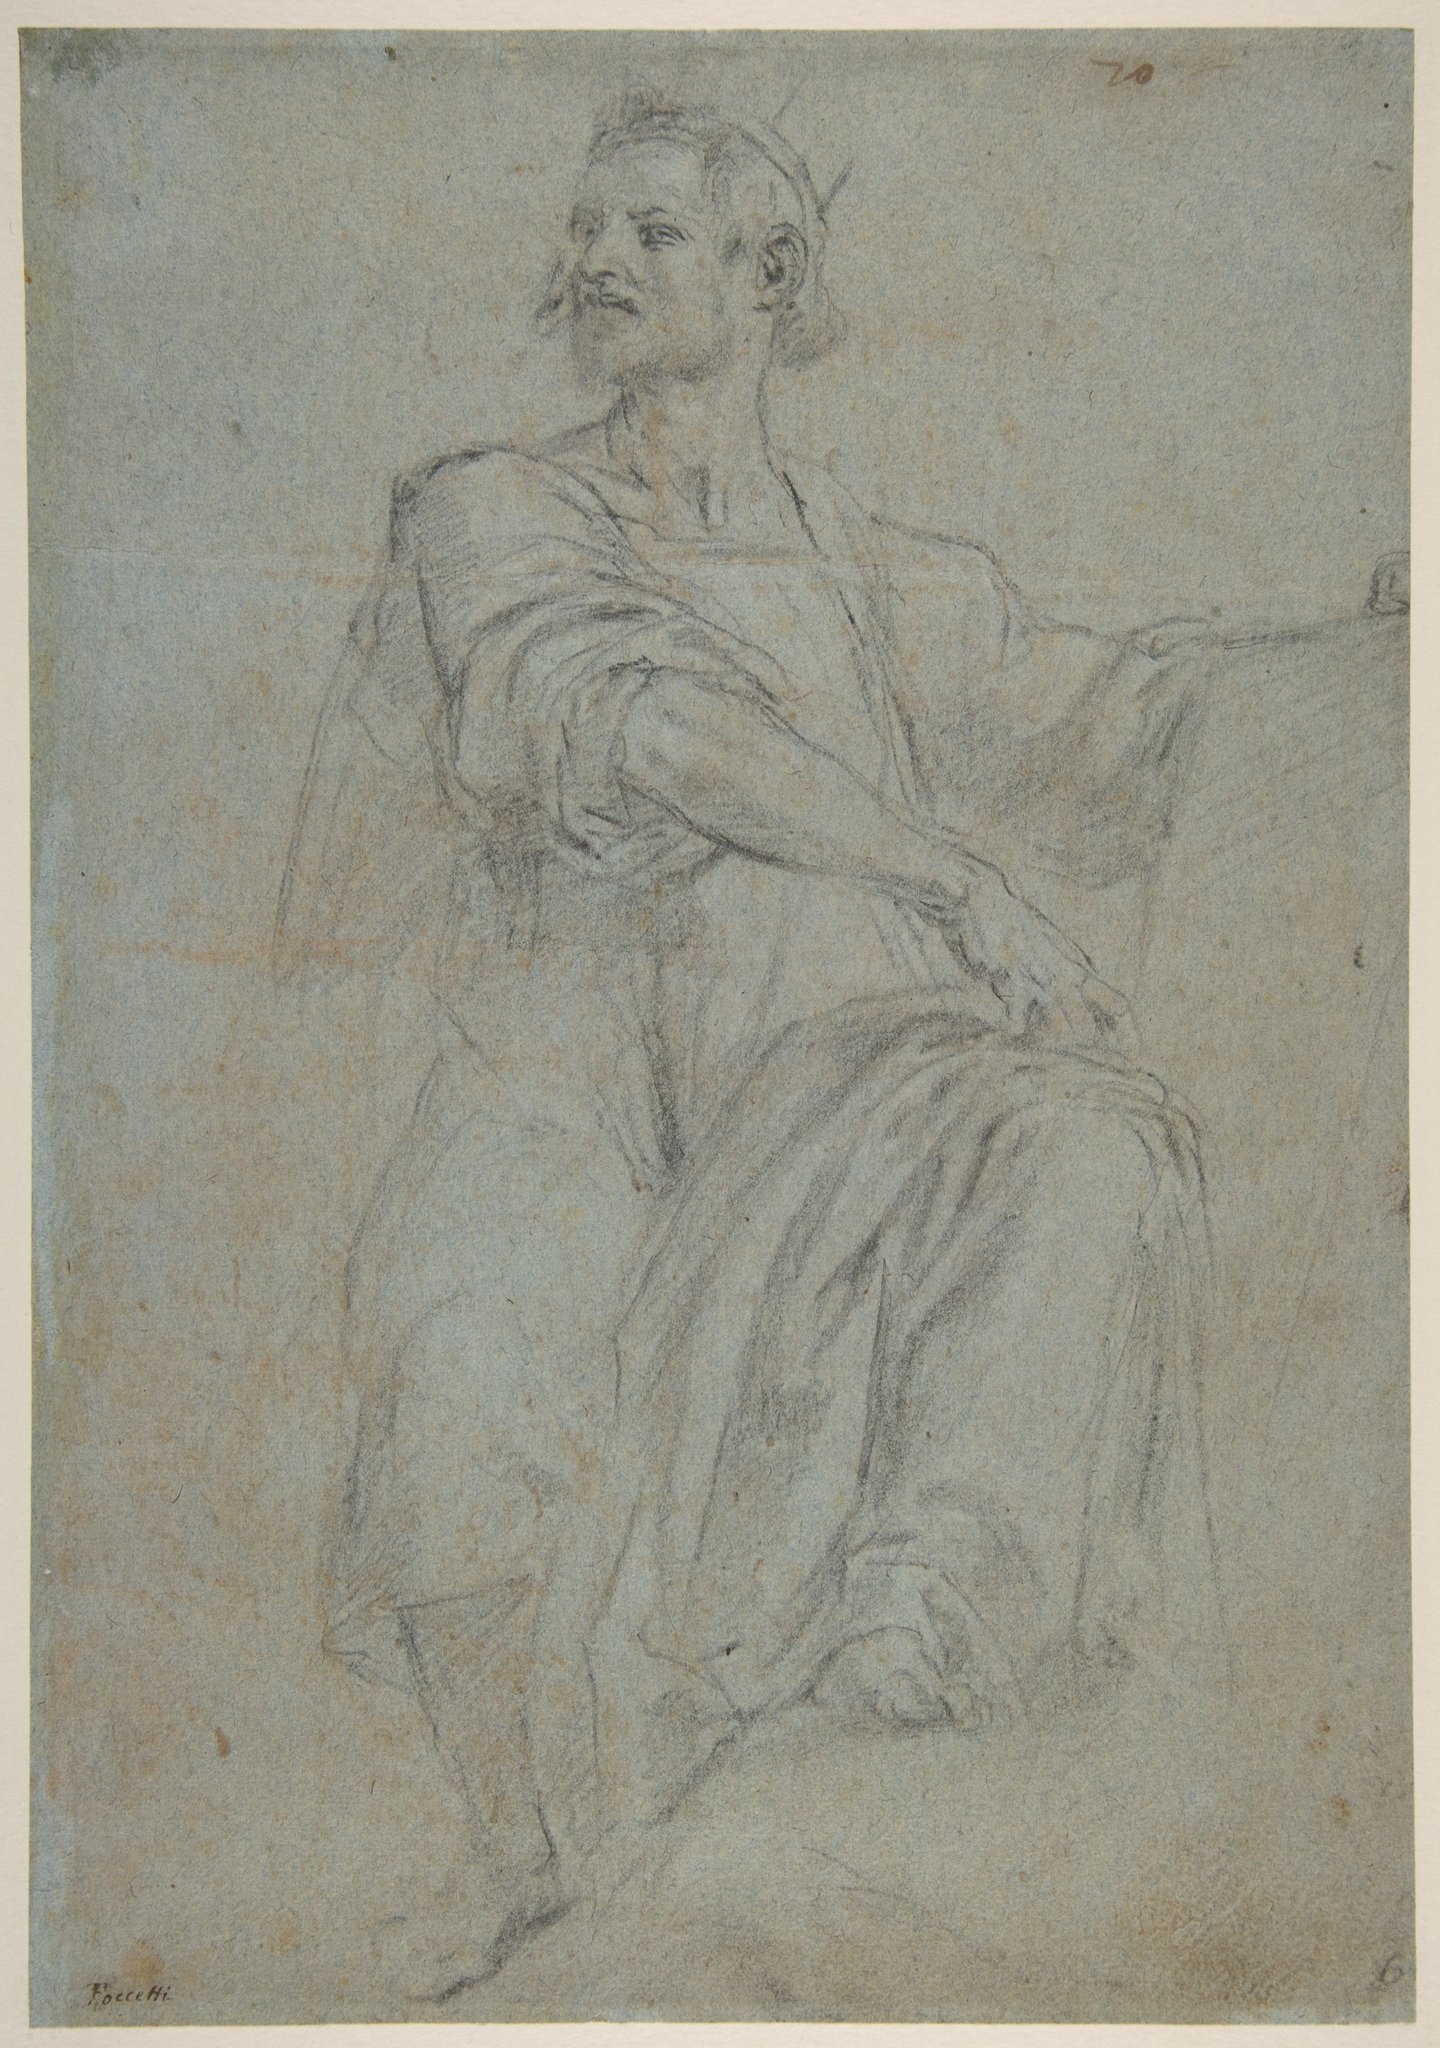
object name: drawing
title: Seated Crowned Male Figure Holding a Book or Scroll (recto); Seated Nude Boy (verso)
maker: bernardino poccetti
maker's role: artist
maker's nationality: italian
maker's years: 1548-1612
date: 1548-1612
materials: charcoal, paper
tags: scrolls,men